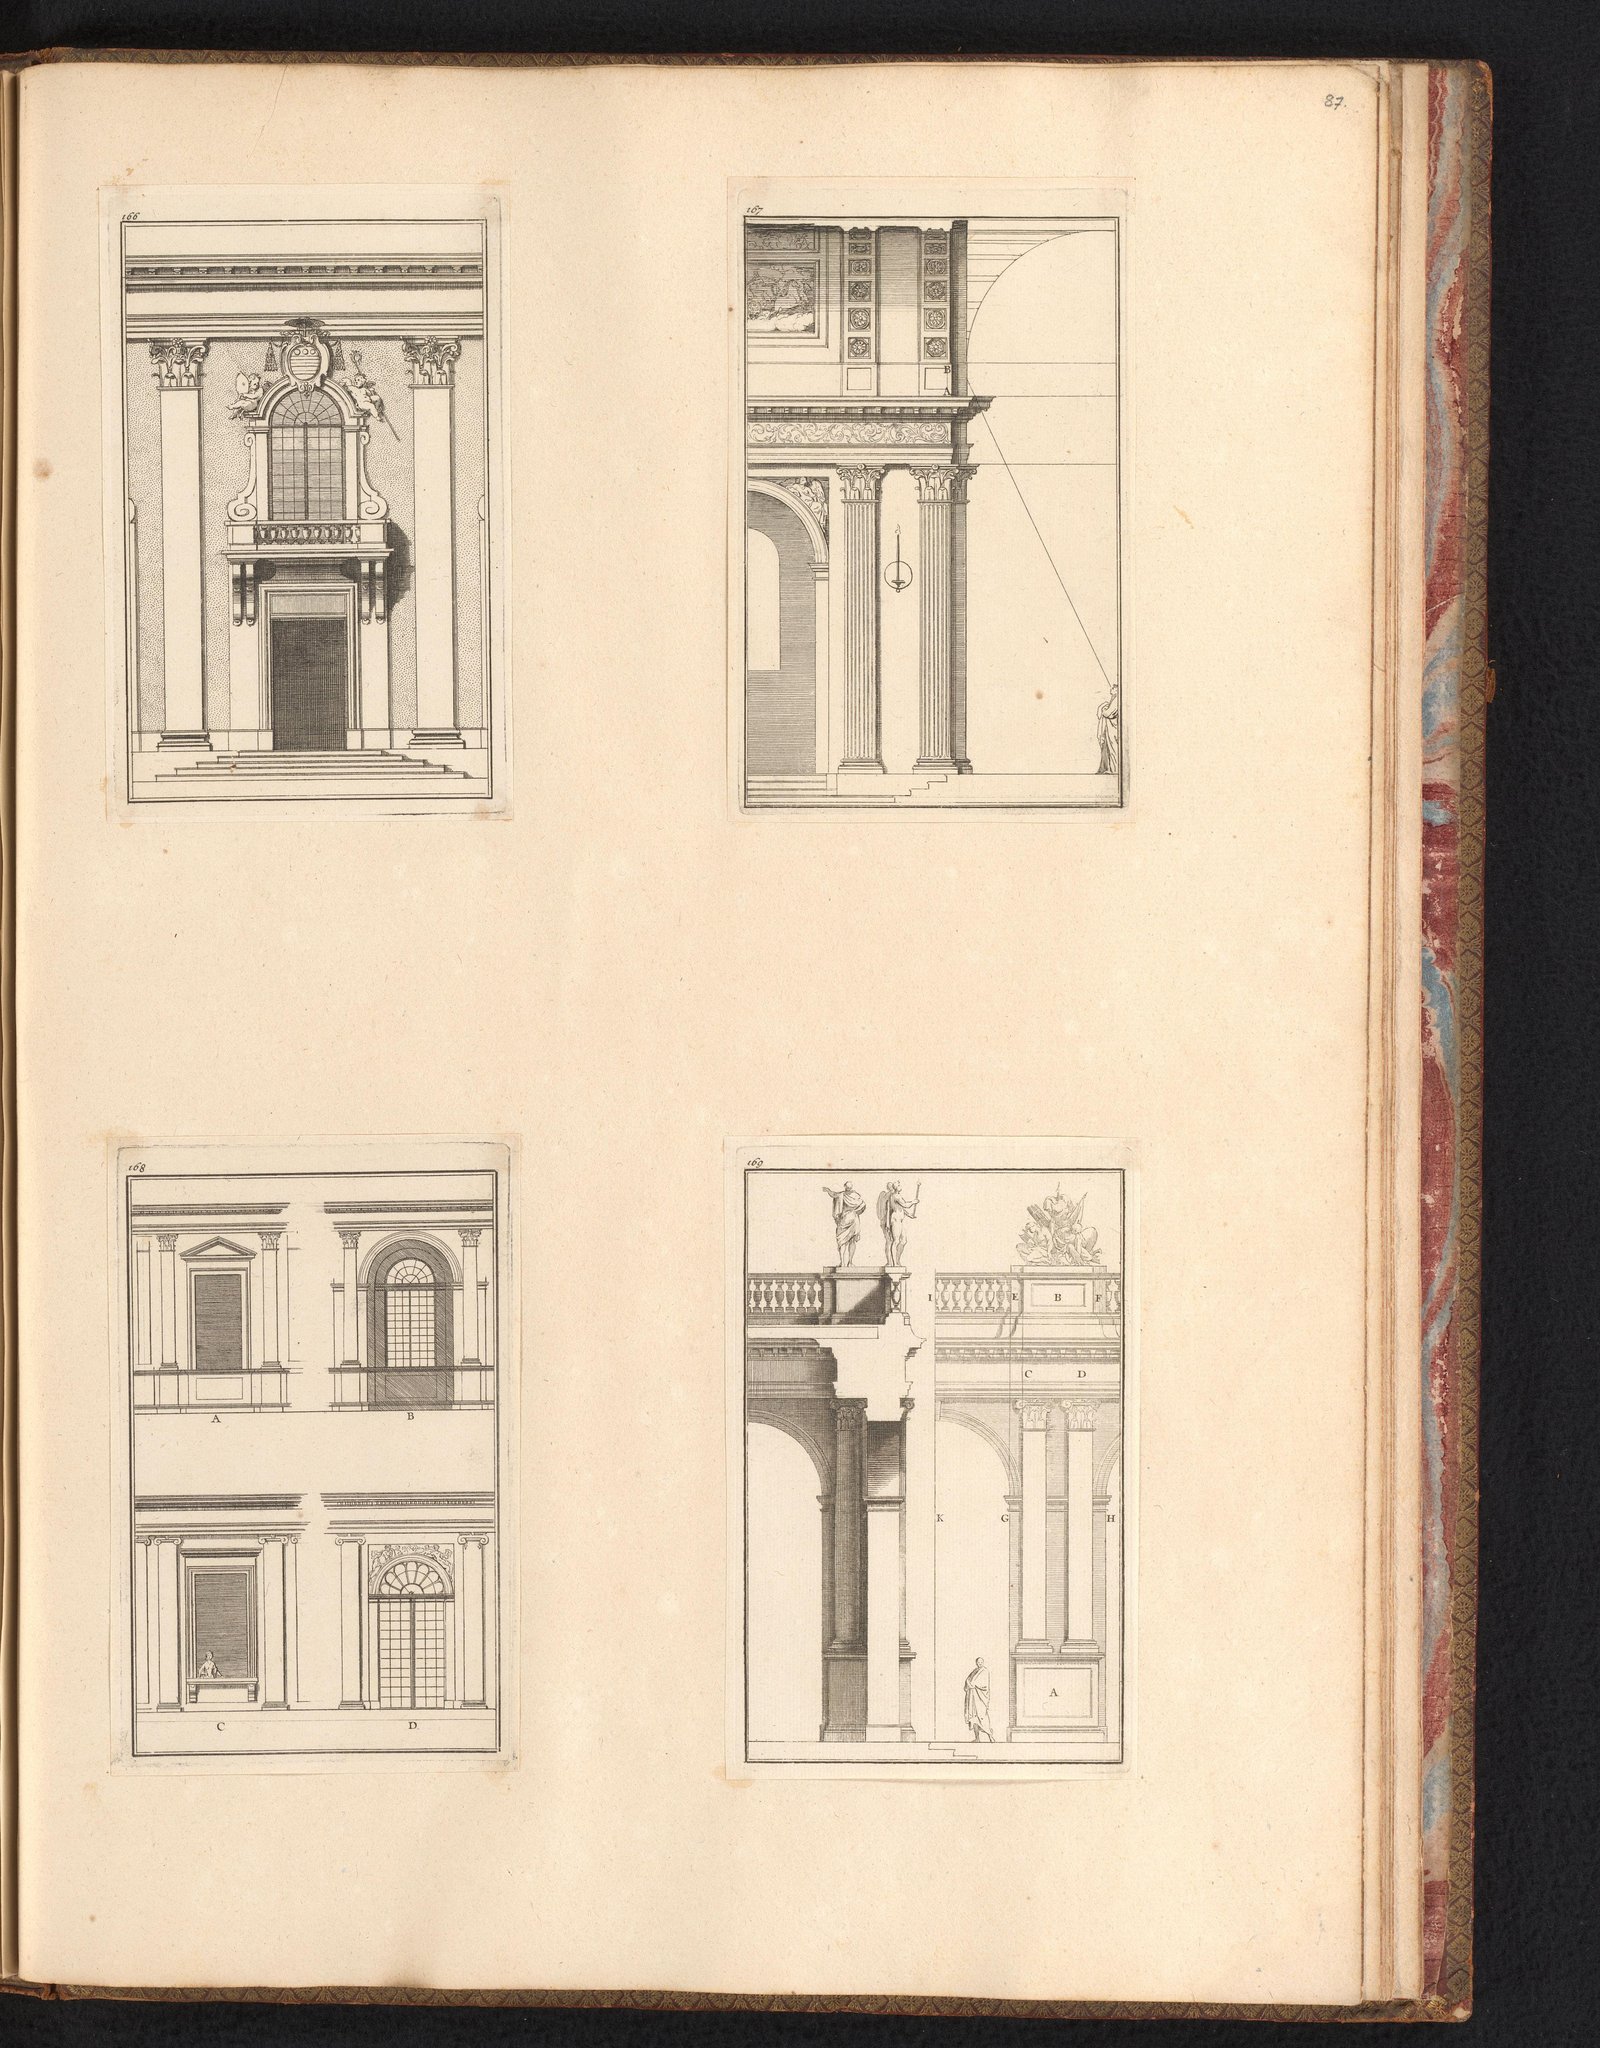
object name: print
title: Klassieke architecturale elementen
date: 1714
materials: paper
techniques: etching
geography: paris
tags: orders, order-books ~ architecture, door, half-column, pilaster ~ architecture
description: Prenten uit: Leclerc, Sébastien (I). Traité d'architecture. Parijs: Pierre François Giffart, 1714.